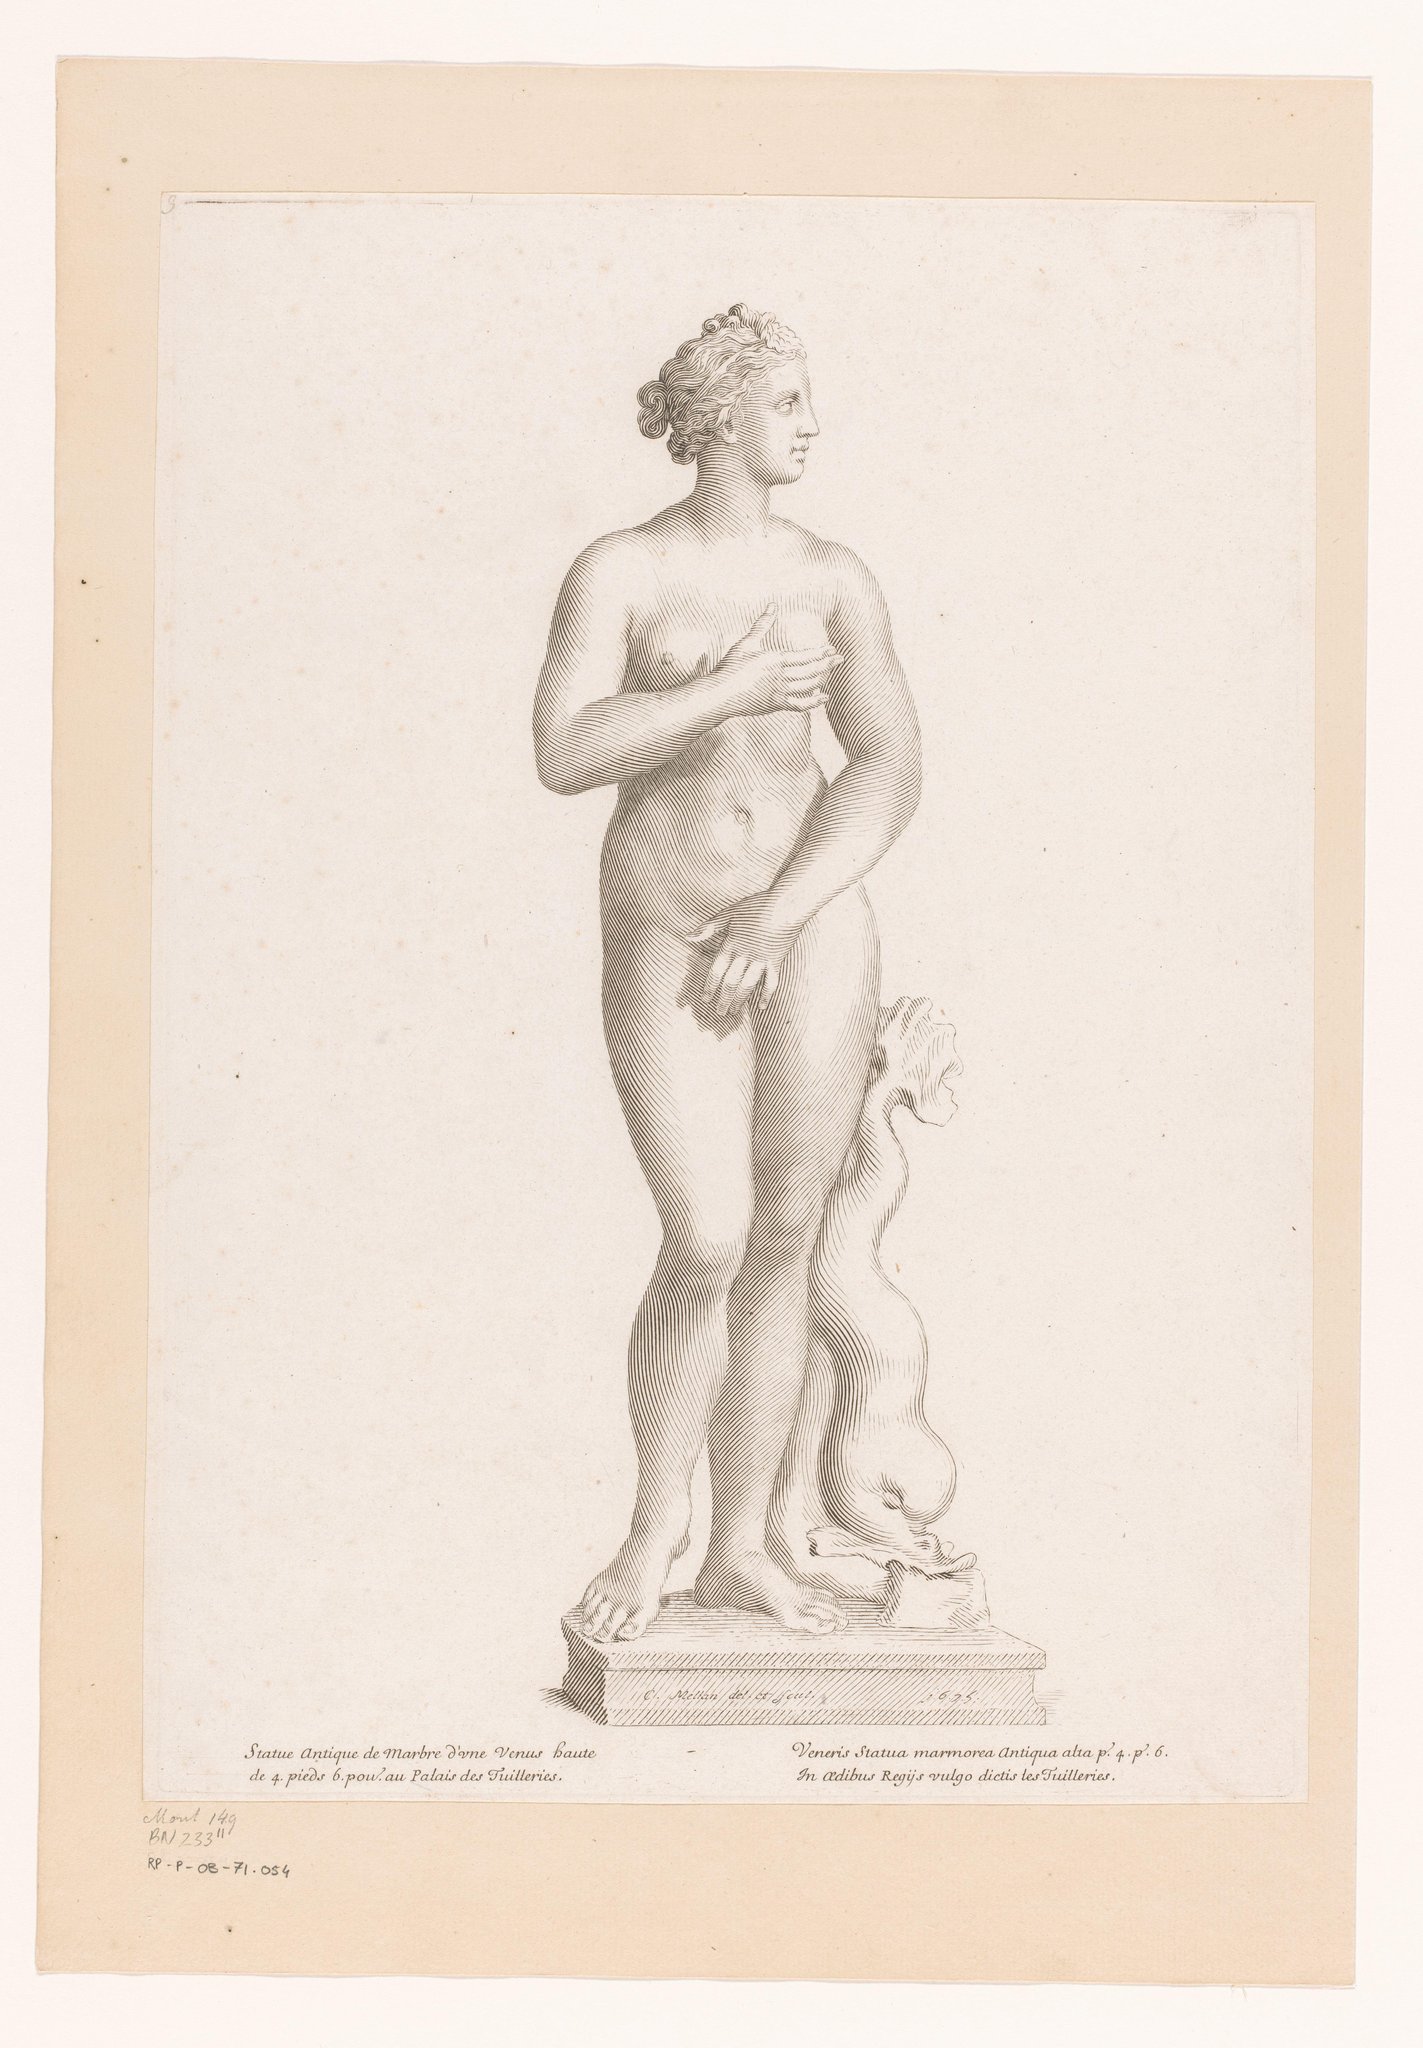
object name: print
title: Standbeeld van Venus of Amphitrite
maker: claude mellan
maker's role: draughtsman, print maker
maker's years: 1598-1688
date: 1675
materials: paper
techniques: engraving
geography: france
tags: (story of) amphitrite, piece of sculpture, reproduction of a piece of sculpture, (story of) venus (aphrodite)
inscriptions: collector's mark: Lugt 240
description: Prent gebruikt voor: Félibien, André. Tableaux du Cabinet du roy. Statues et bustes antiques des maisons royales. Parijs: Imprimerie Royale, 1677. Het boek bevat 61 prenten van beelden en bustes uit Franse koninklijke collectie. Mellan vervaardigde in totaal achttien platen (zie ook British Museum, inv.nr. 1874,0808.1488). Het beeld bevindt zich in de Galerie des Glaces te Versailles. De dolfijn op de prent betreft in werkelijkheid een lap draperie.